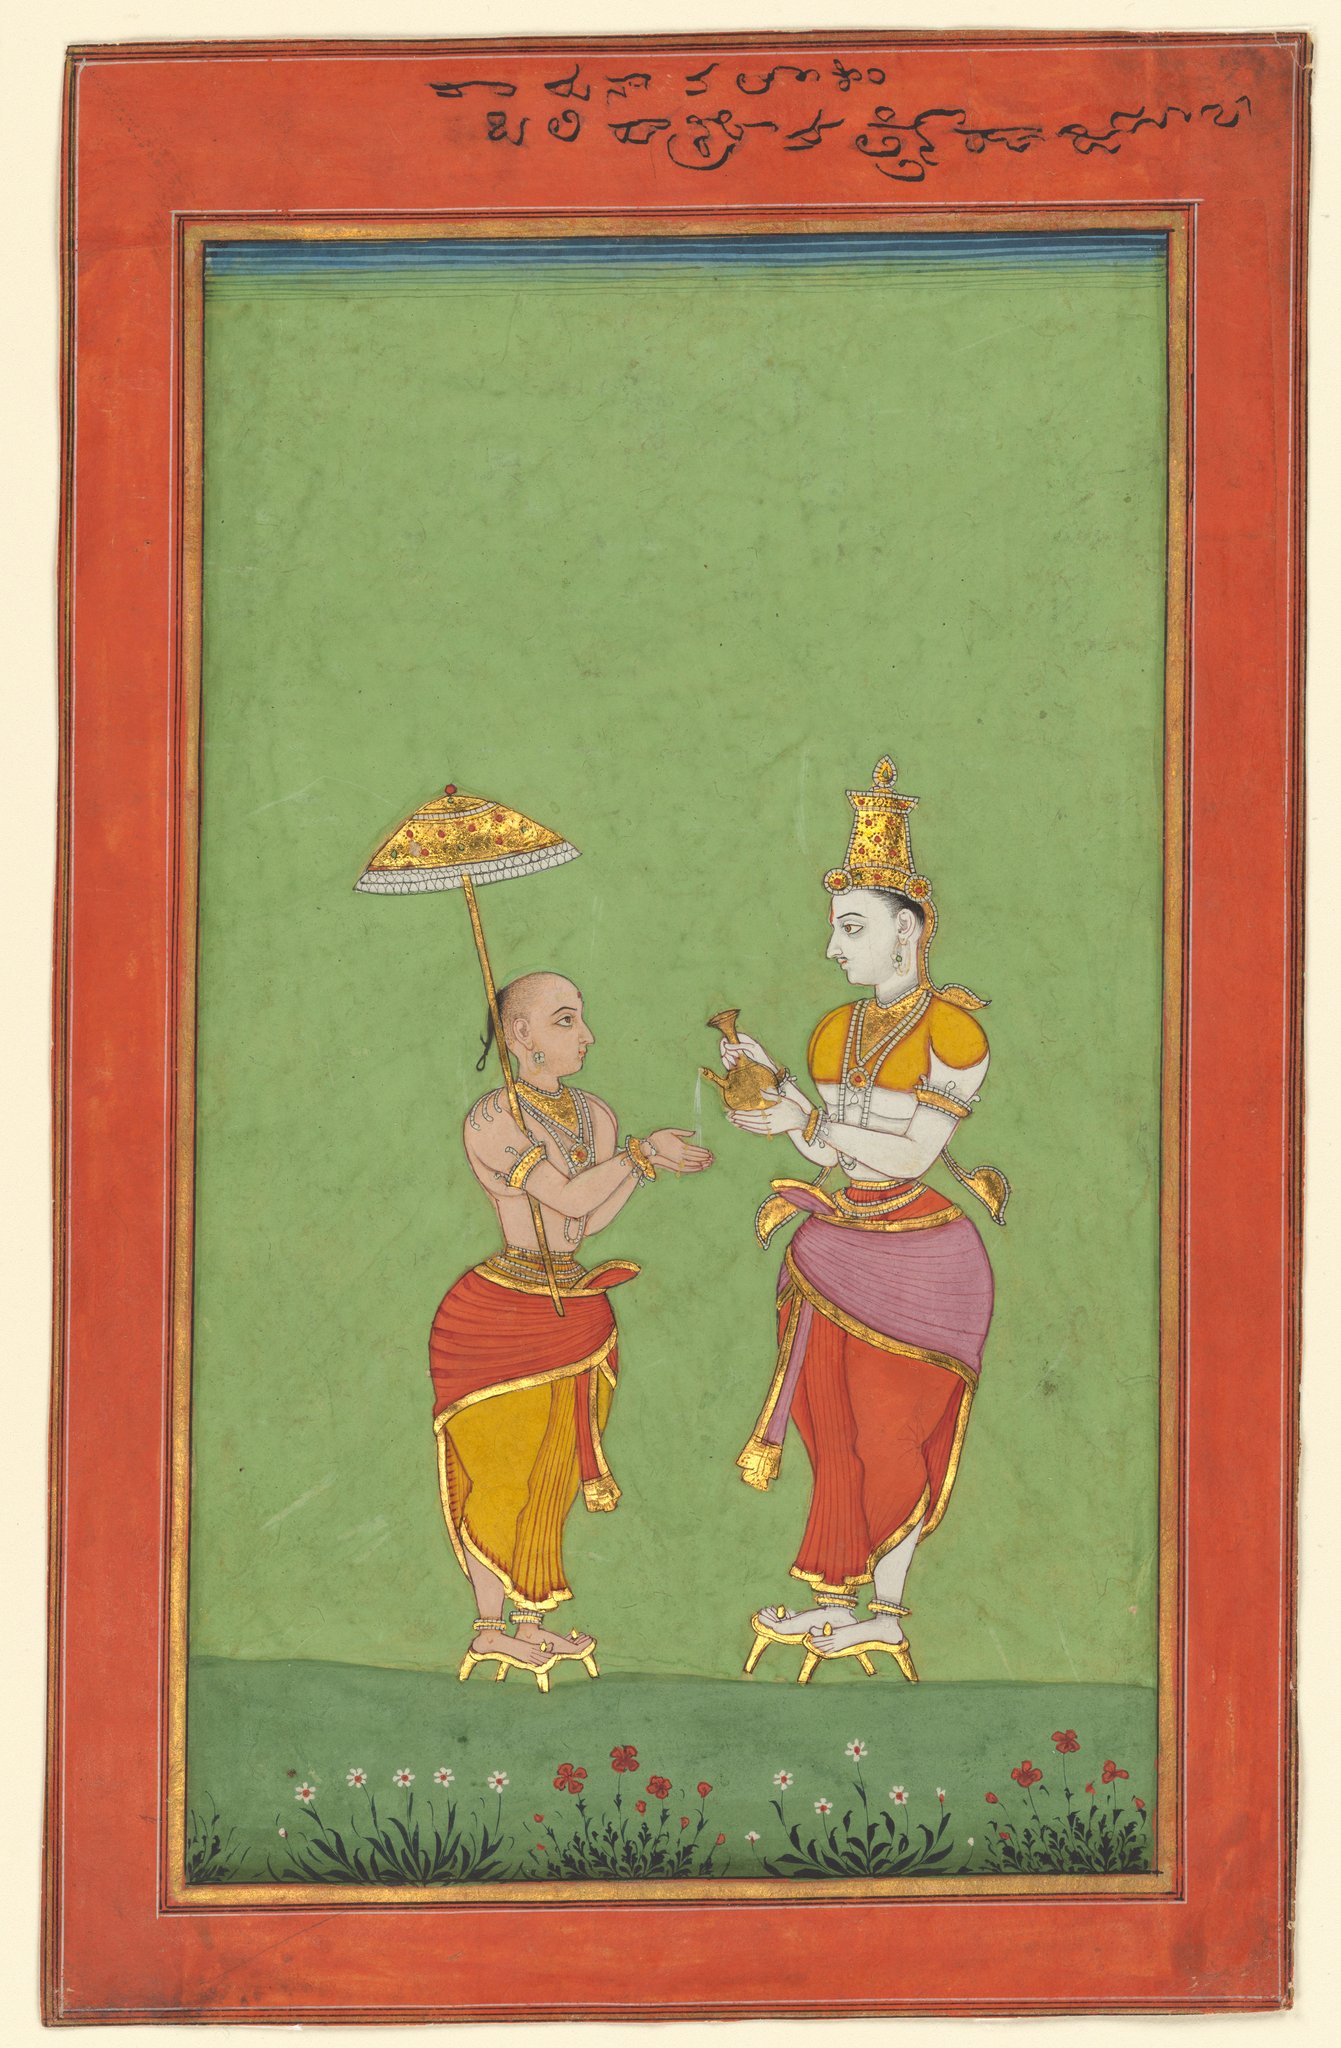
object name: folio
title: Vamana being blessed by King Bali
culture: indian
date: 1780-1789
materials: gold, paper, pigment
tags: kings,men,ewers,parasols